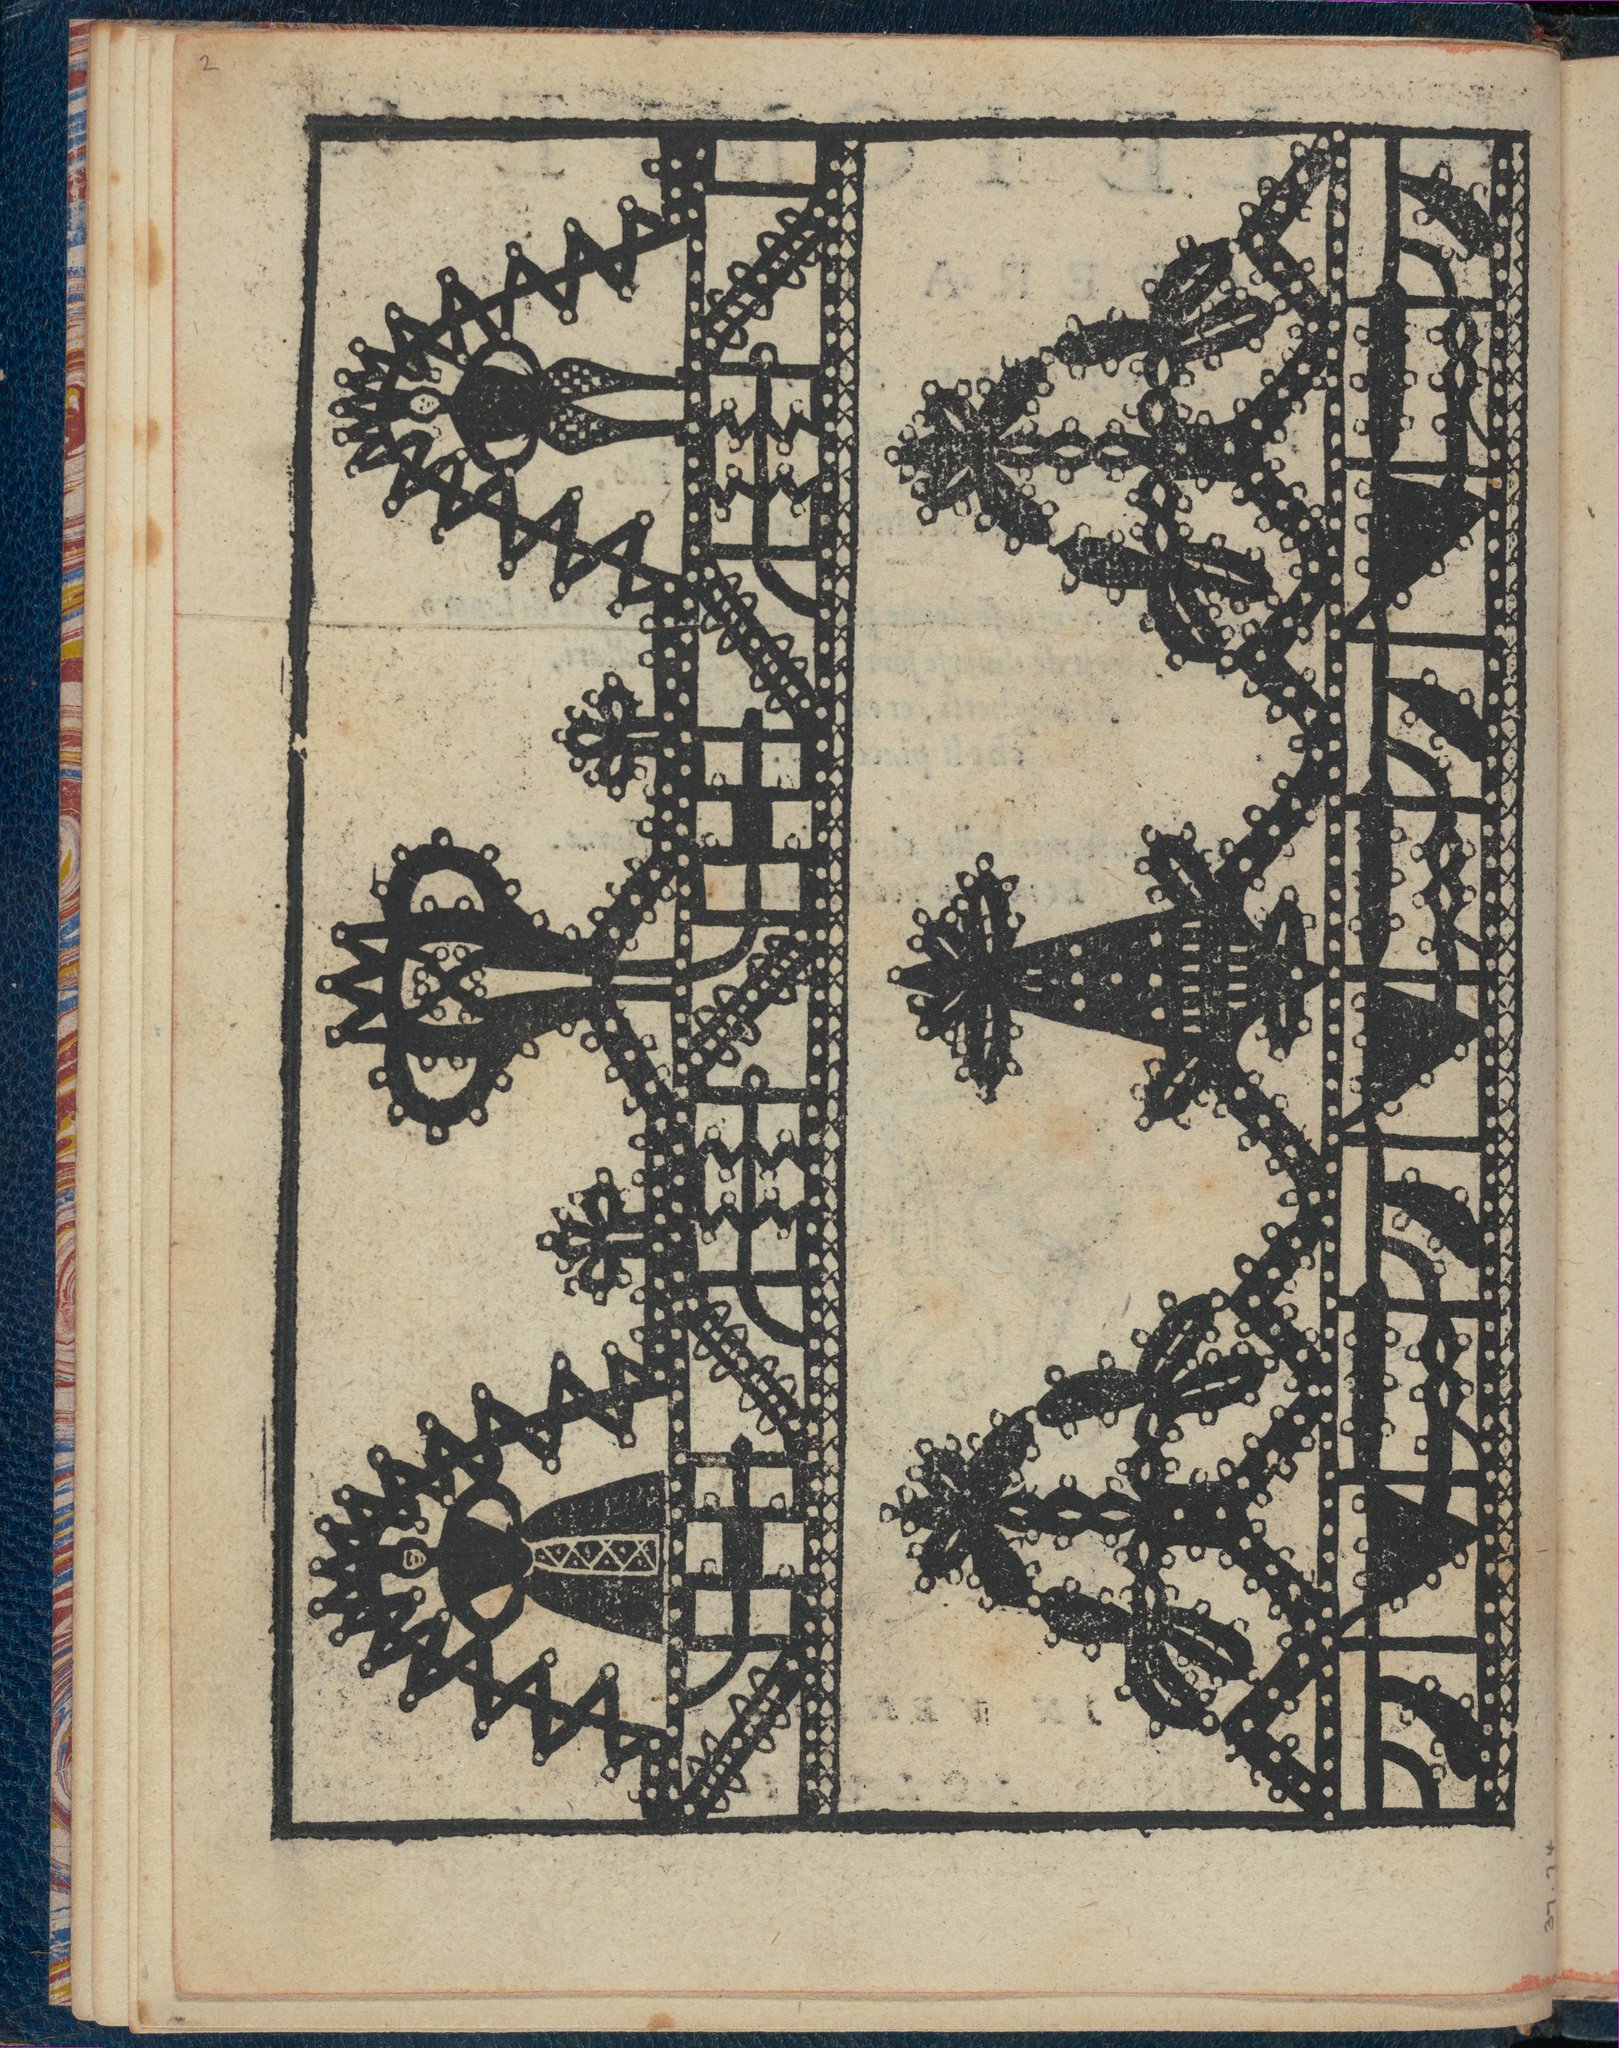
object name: book print ornament architecture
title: Le Pompe: Opera Nova, title page (verso)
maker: giovanni battista & marchio sessa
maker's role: publisher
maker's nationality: italian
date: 1557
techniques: woodcut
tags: ornament